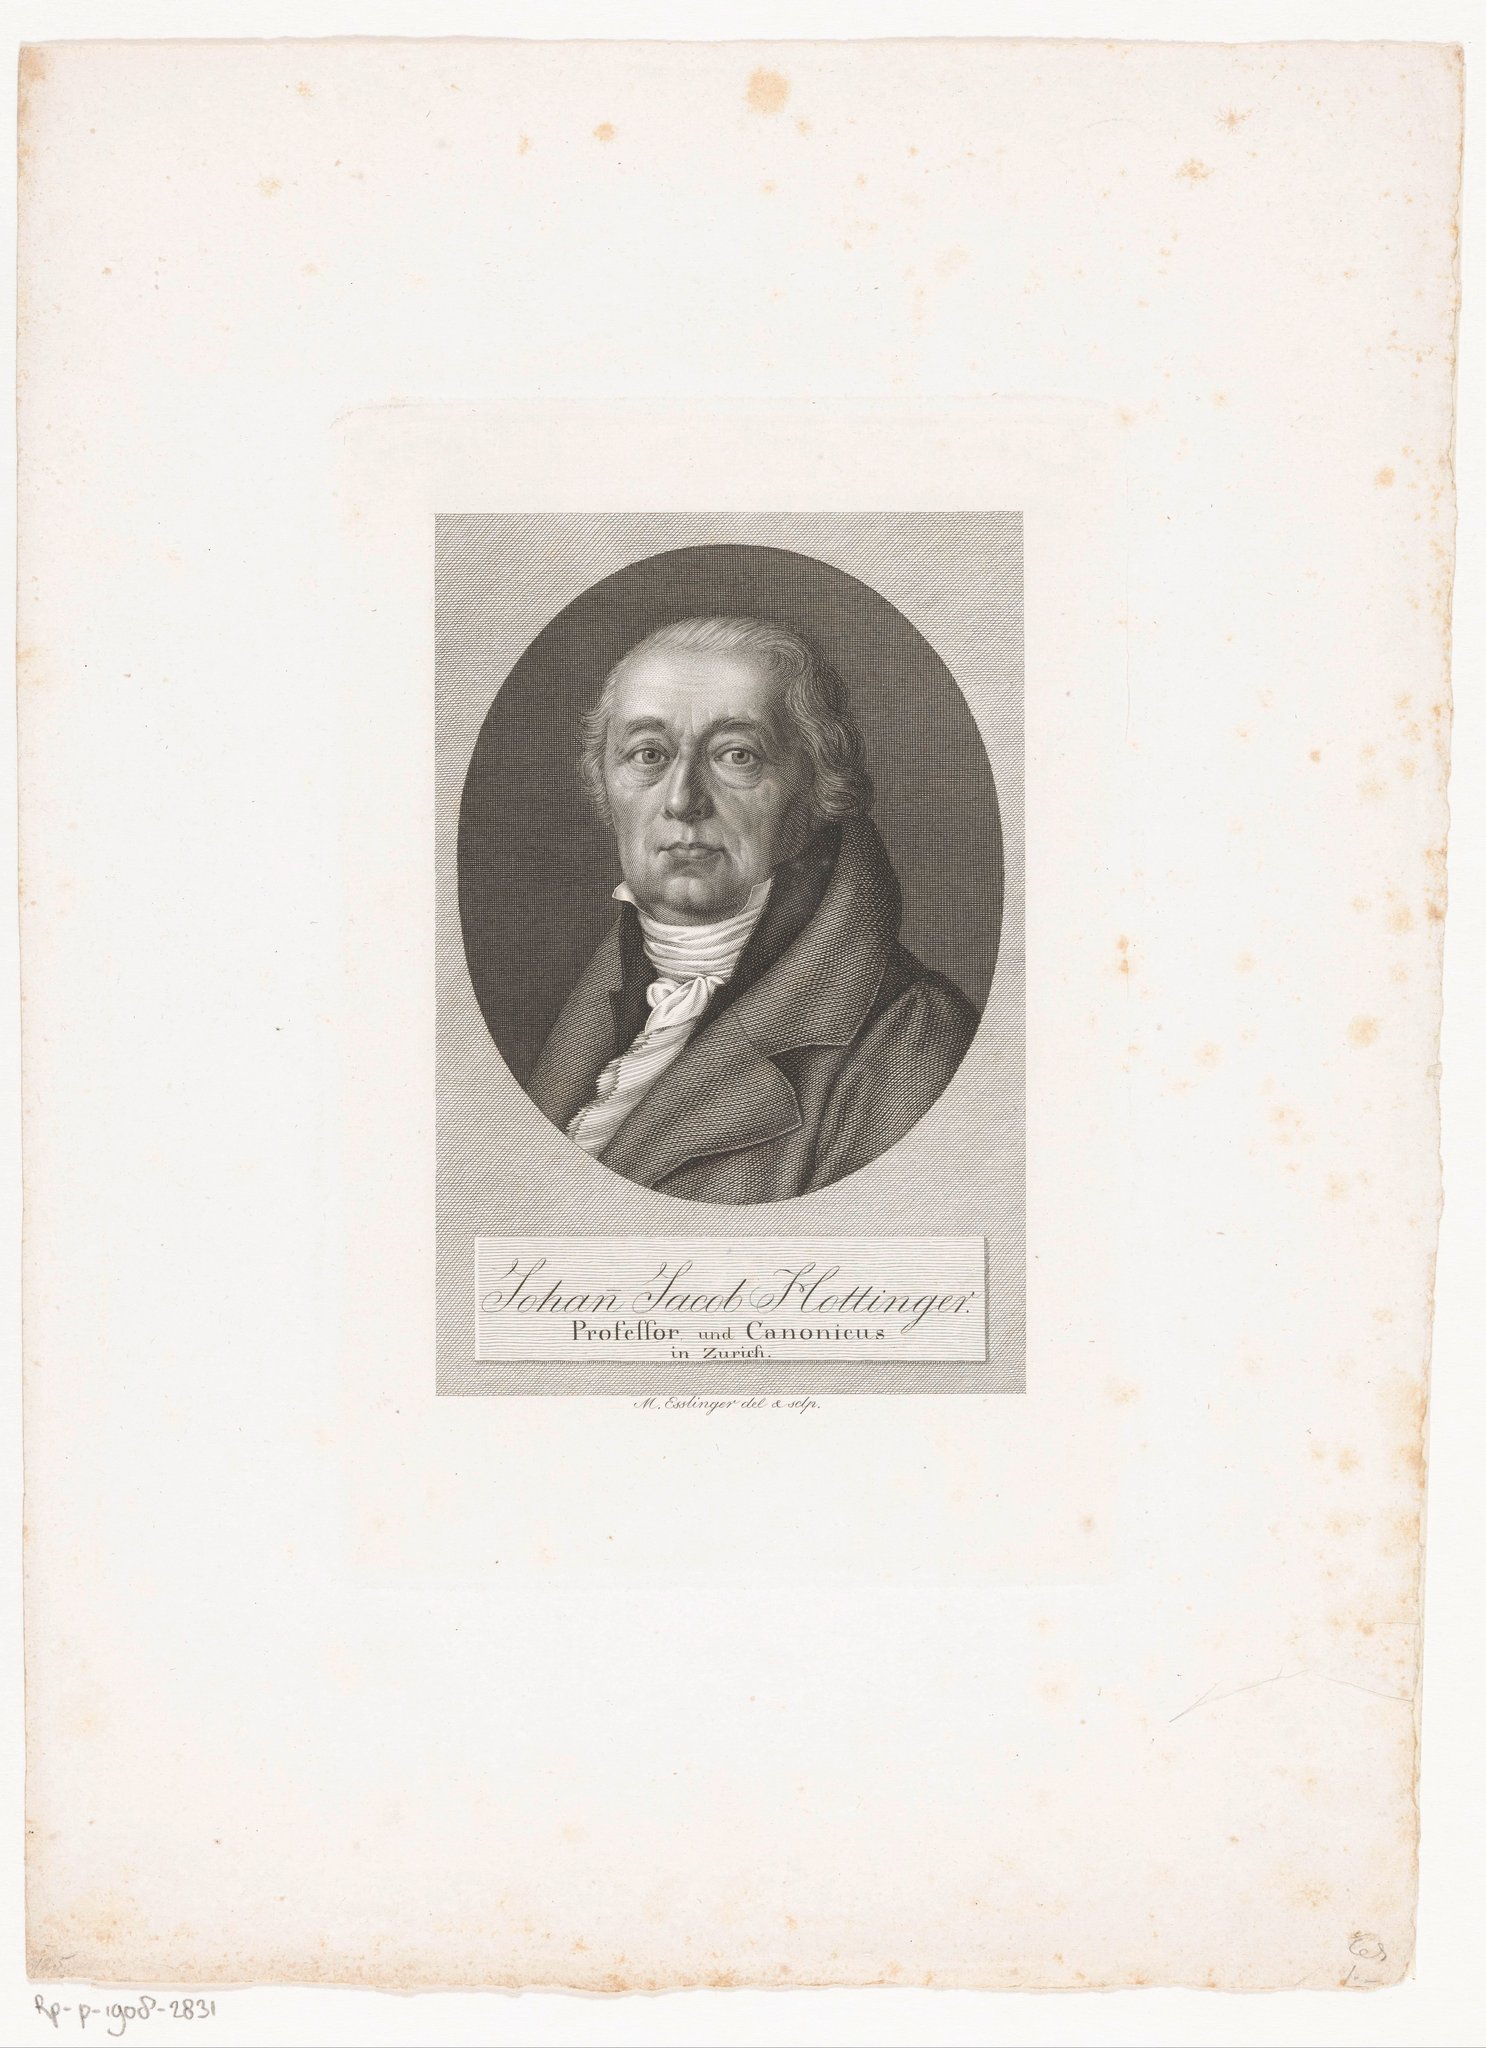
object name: print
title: Portret van Johann Jakob Hottinger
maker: martin esslinger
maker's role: print maker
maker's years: 1793-1841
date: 1803-1819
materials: paper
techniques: engraving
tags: historical persons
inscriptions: collector's mark: Lugt 2228